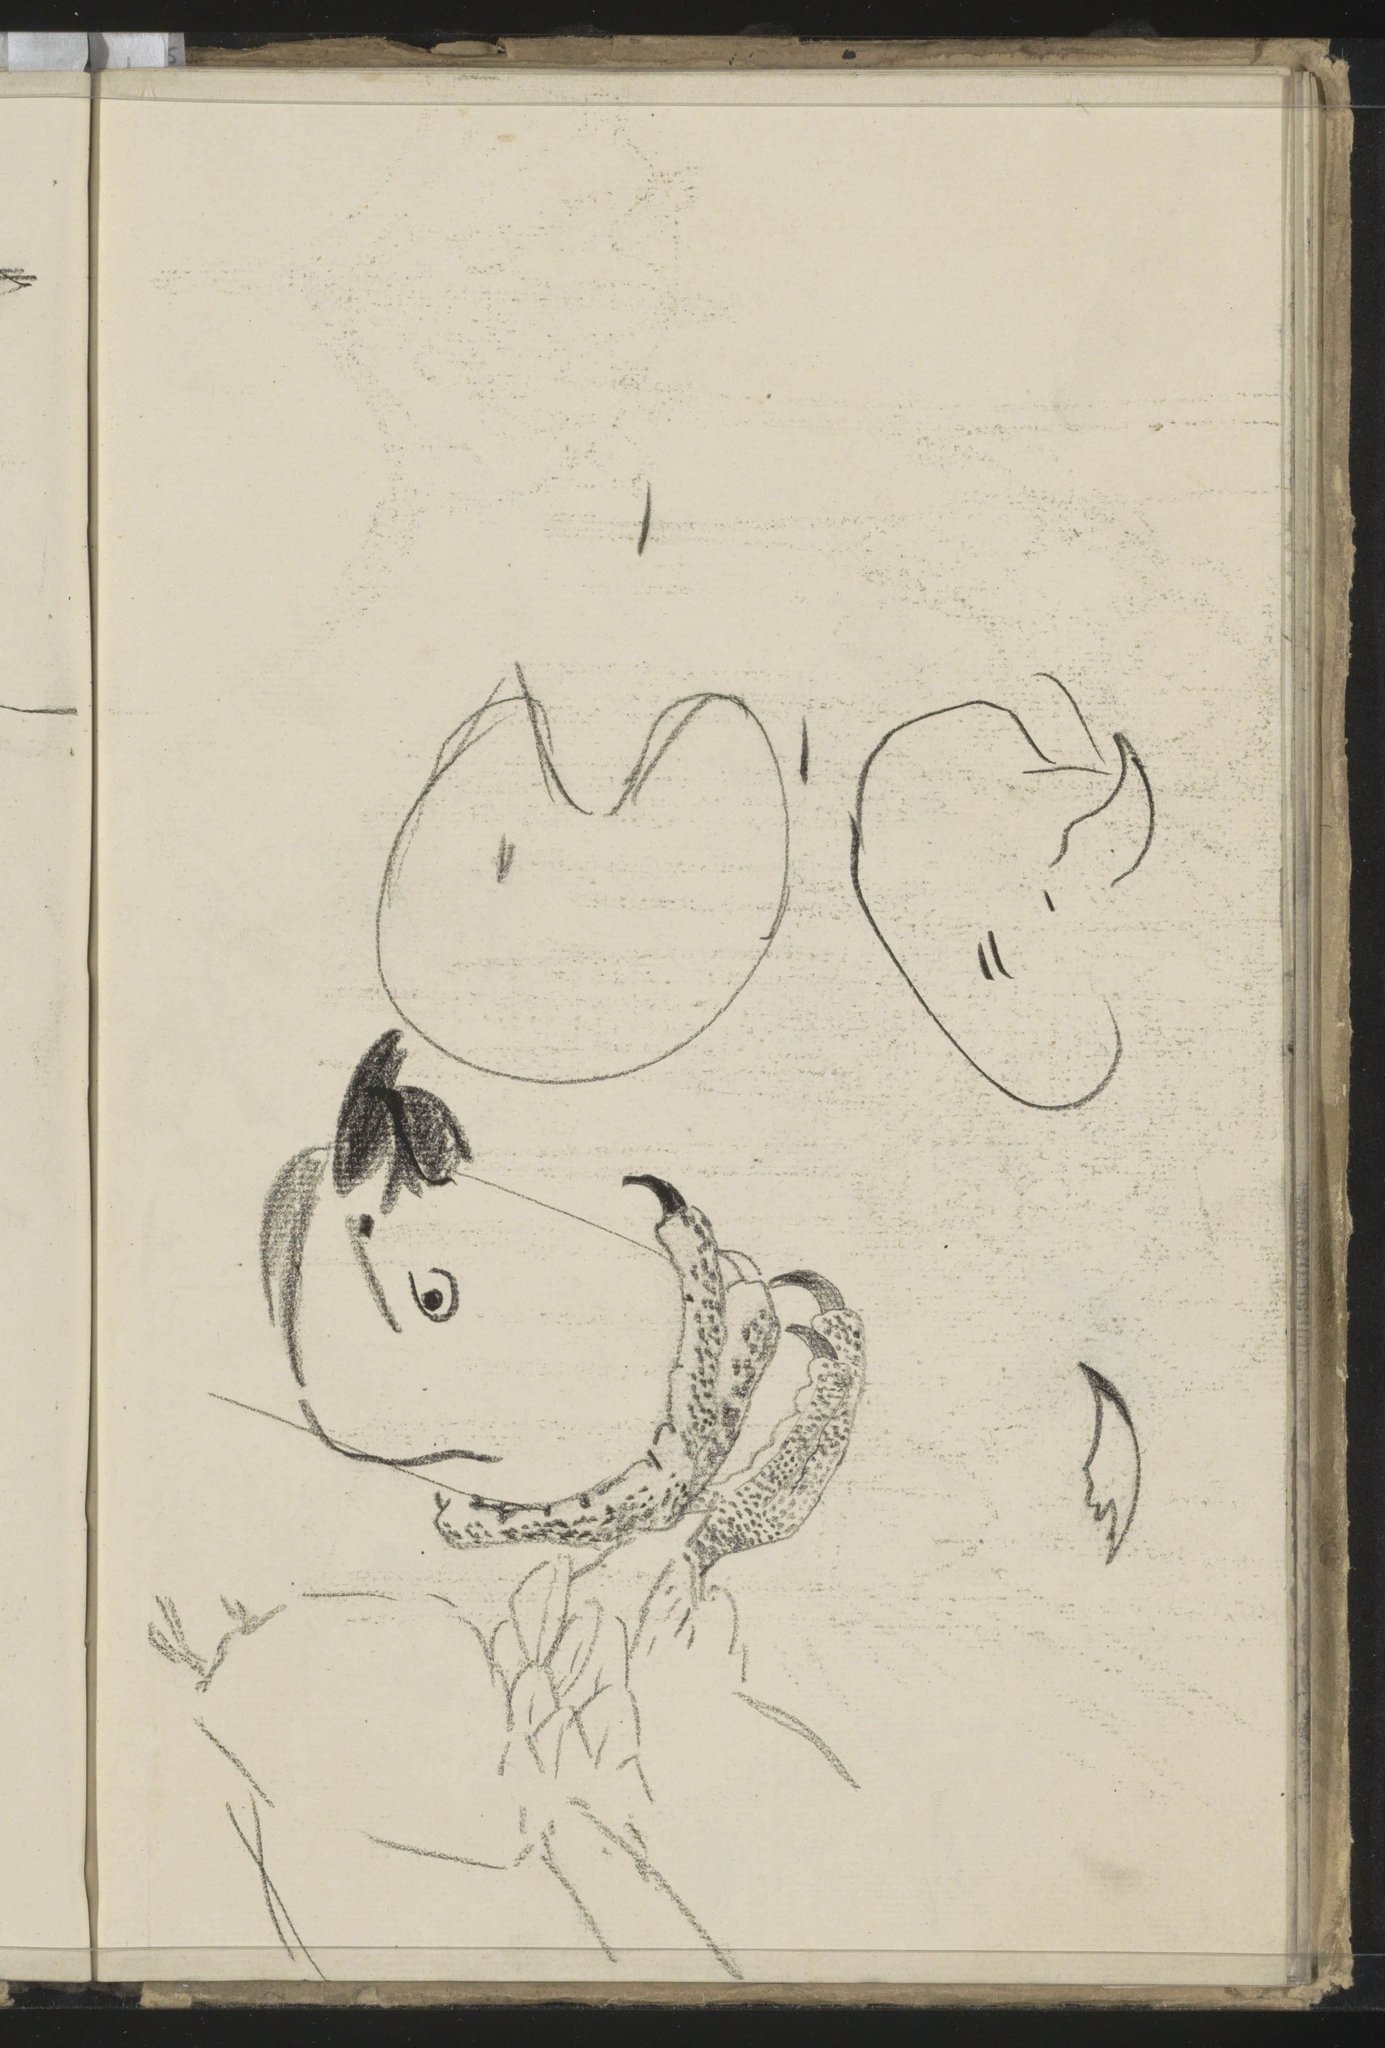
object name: sketchbook leaf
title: Kop van een papegaai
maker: carel adolph lion cachet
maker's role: draughtsman, print maker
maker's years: 1864-1945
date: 1890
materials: chalk, paper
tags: ornamental birds: parrot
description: Blad 22 recto uit een schetsboek met 38 bladen.